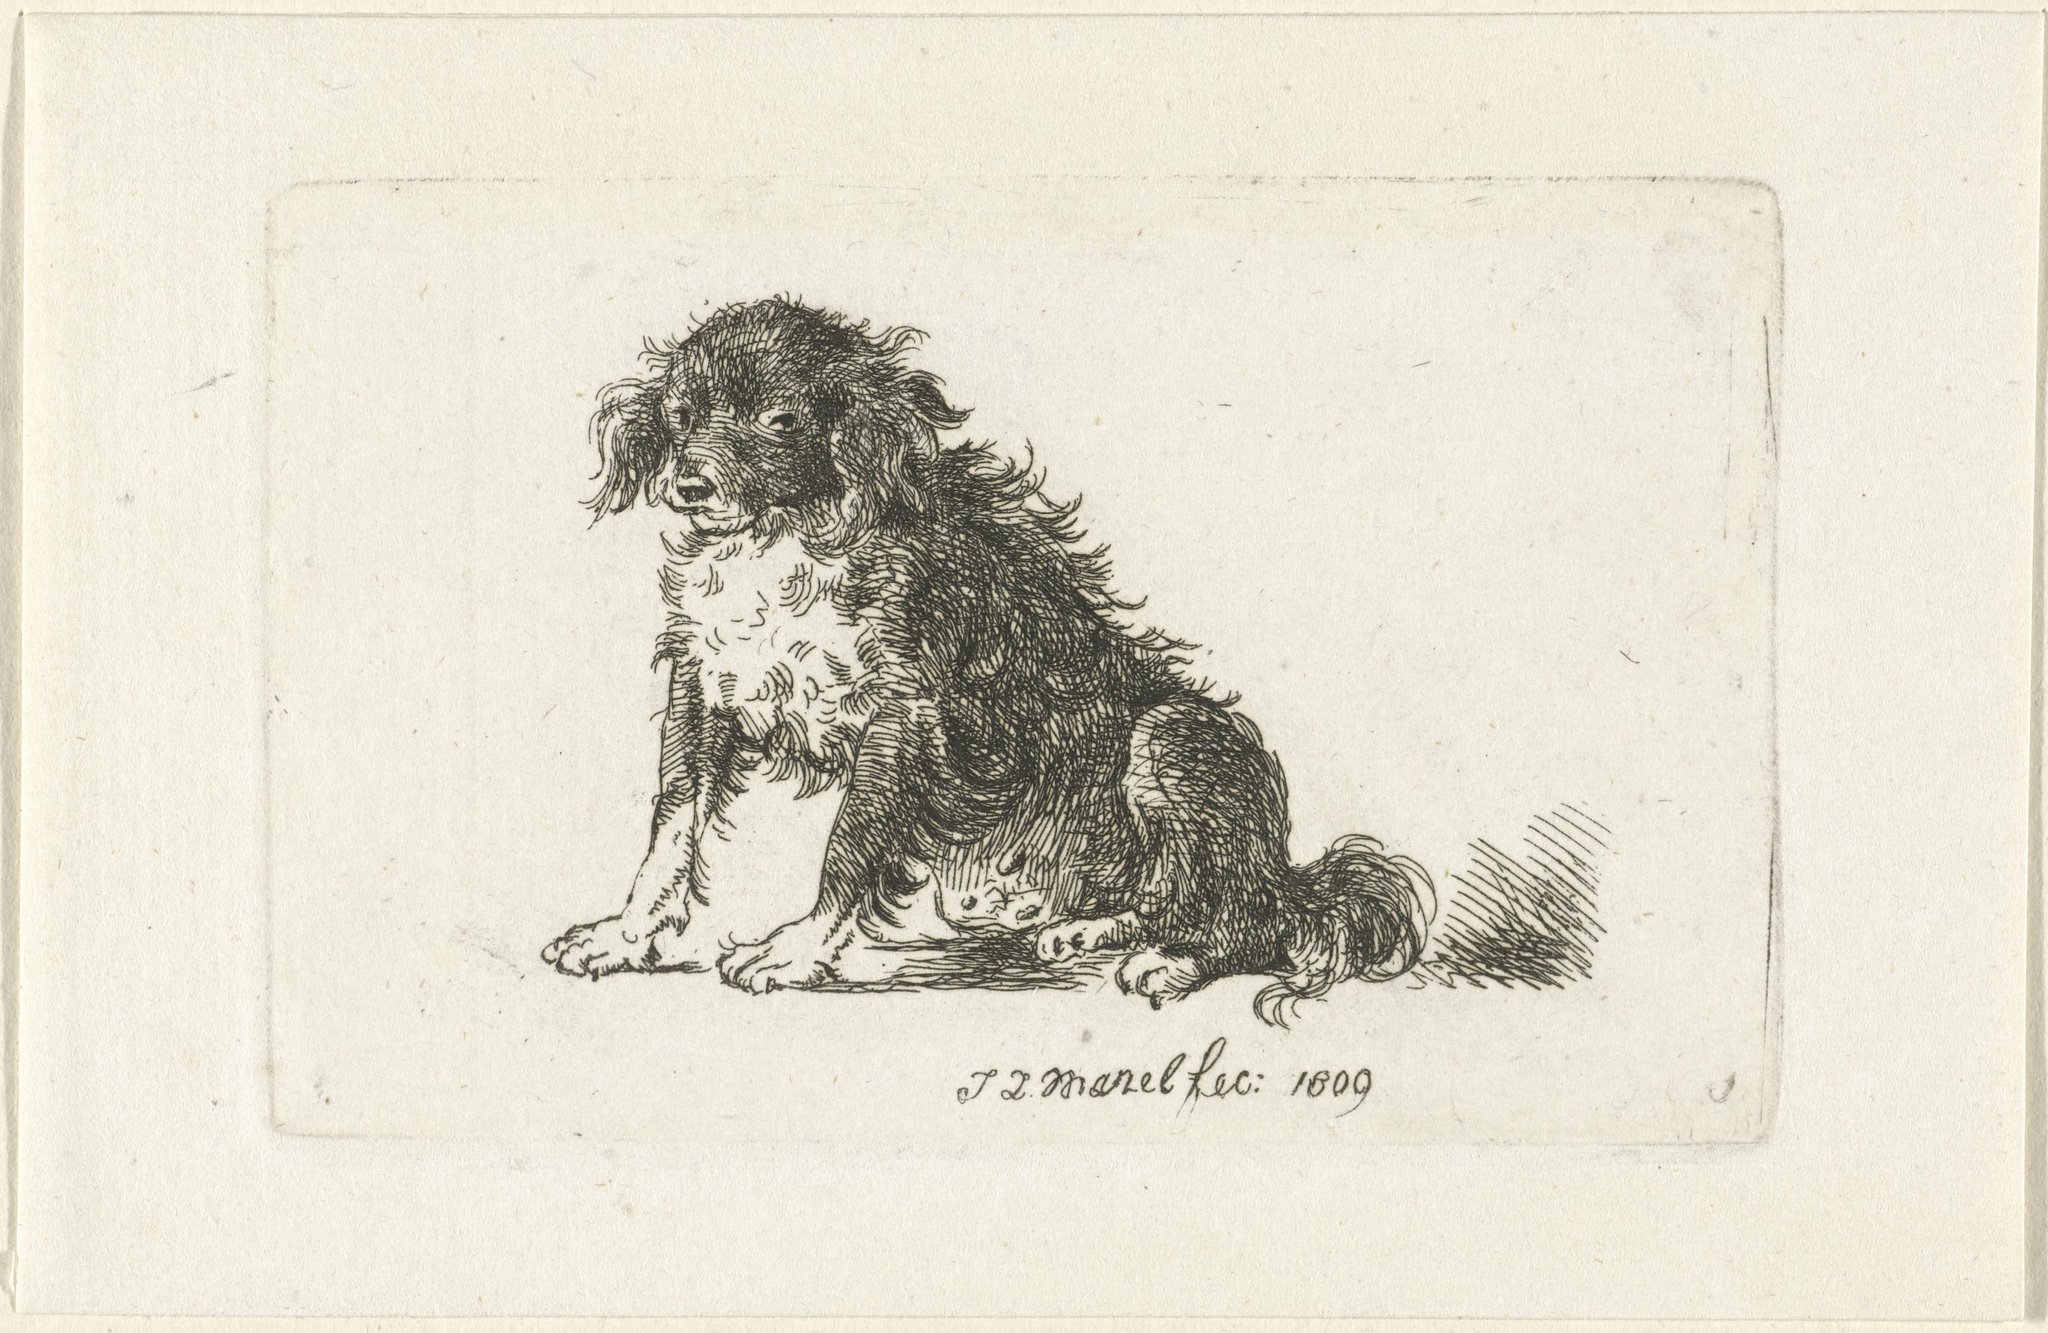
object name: print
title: Zittende hond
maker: jean zacherie mazel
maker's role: draughtsman, print maker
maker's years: 1792-1884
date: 1809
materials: paper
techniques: etching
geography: netherlands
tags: dog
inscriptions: collector's mark: Lugt 2760, collector's mark: Lugt 2228